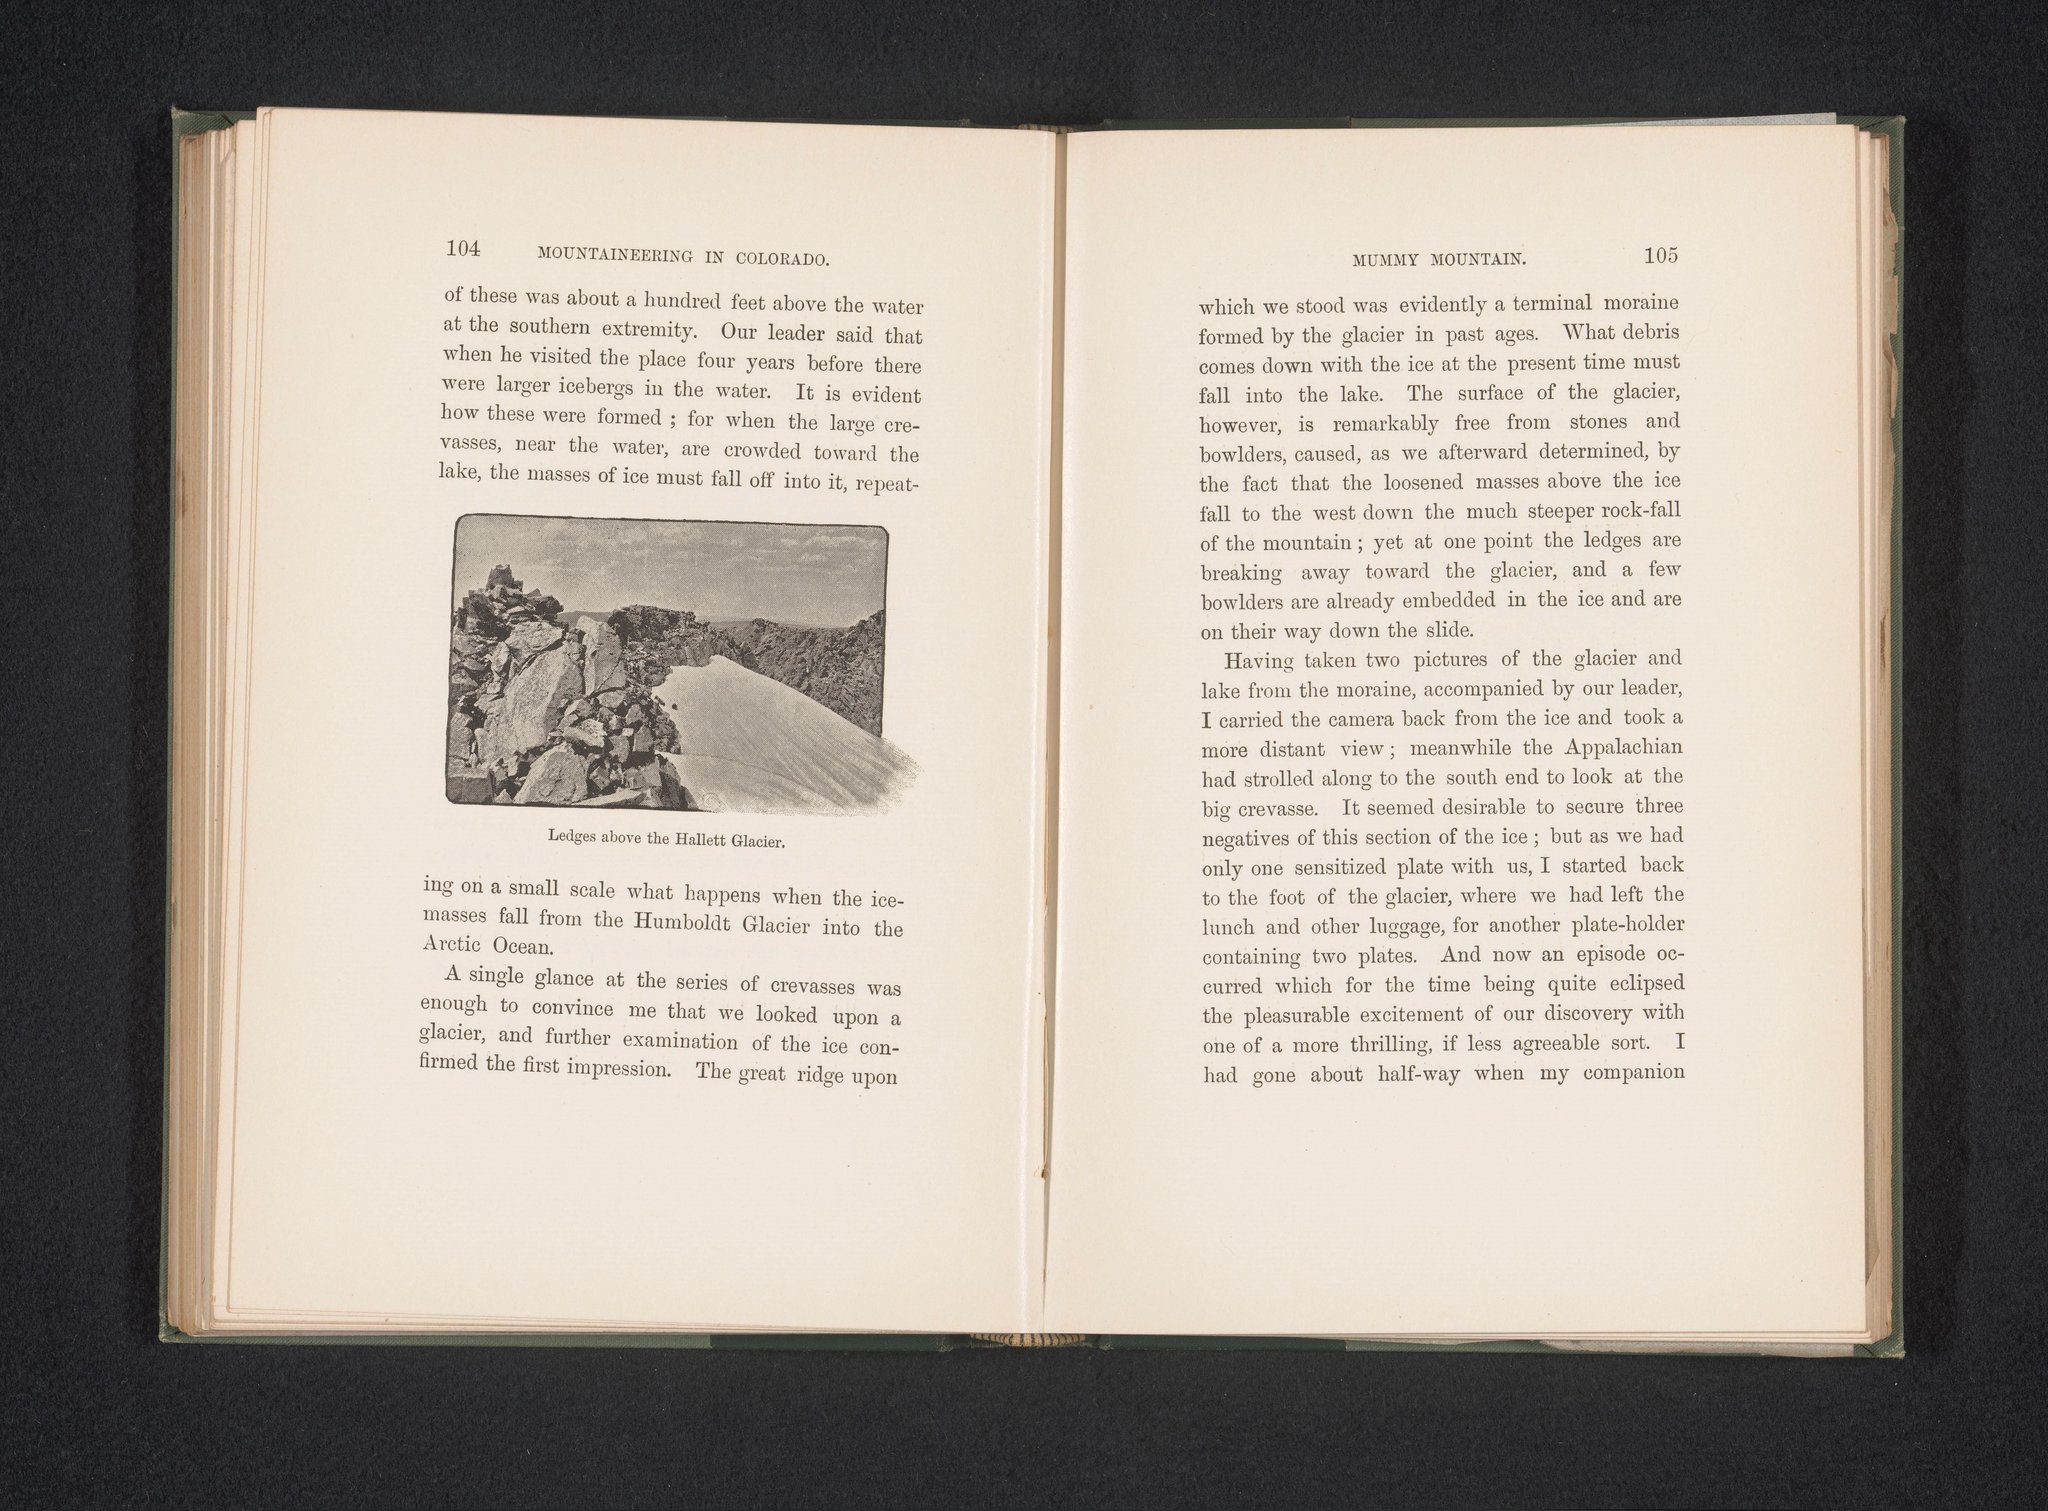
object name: photomechanical print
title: Ledges above the Hallett glacier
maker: frederick hastings chapin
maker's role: antropoloog, archeoloog, fotograaf, schrijver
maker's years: 1852-1900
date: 1885-1890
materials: paper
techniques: autotype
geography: rocky mountain national park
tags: landscapes, glacier, mountains